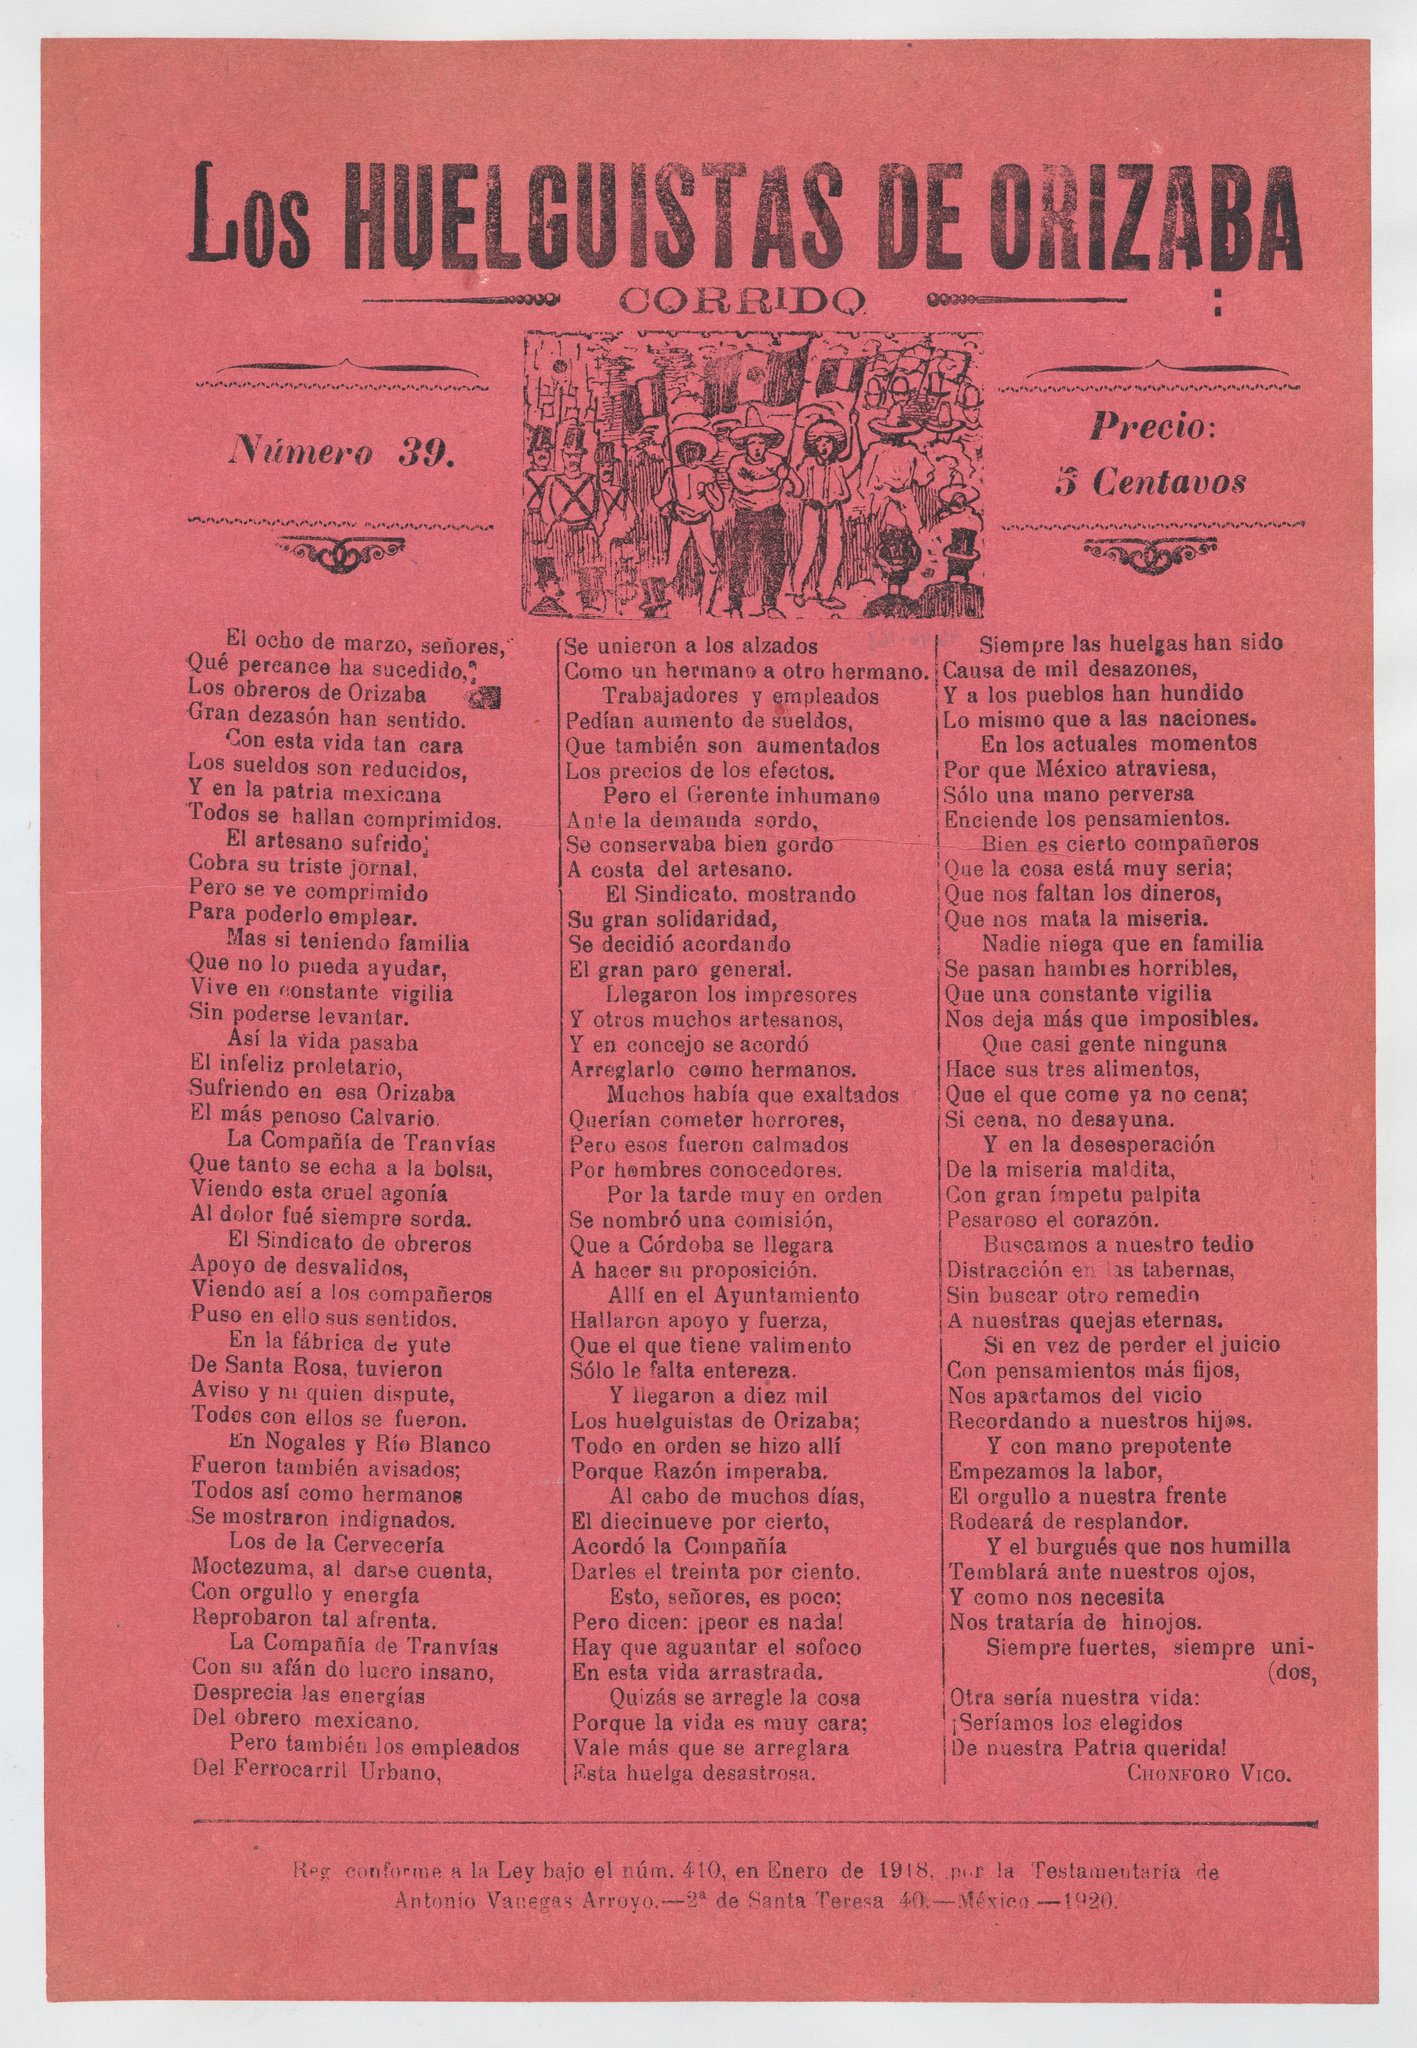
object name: print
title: Broadsheet relating to a worker's strike in Orizaba, workers holding up the Mexican flag, flanked by soldiers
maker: josé guadalupe posada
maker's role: artist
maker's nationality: mexican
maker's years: 1852-1913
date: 1920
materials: paper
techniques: letterpress, lithography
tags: soldiers,flags